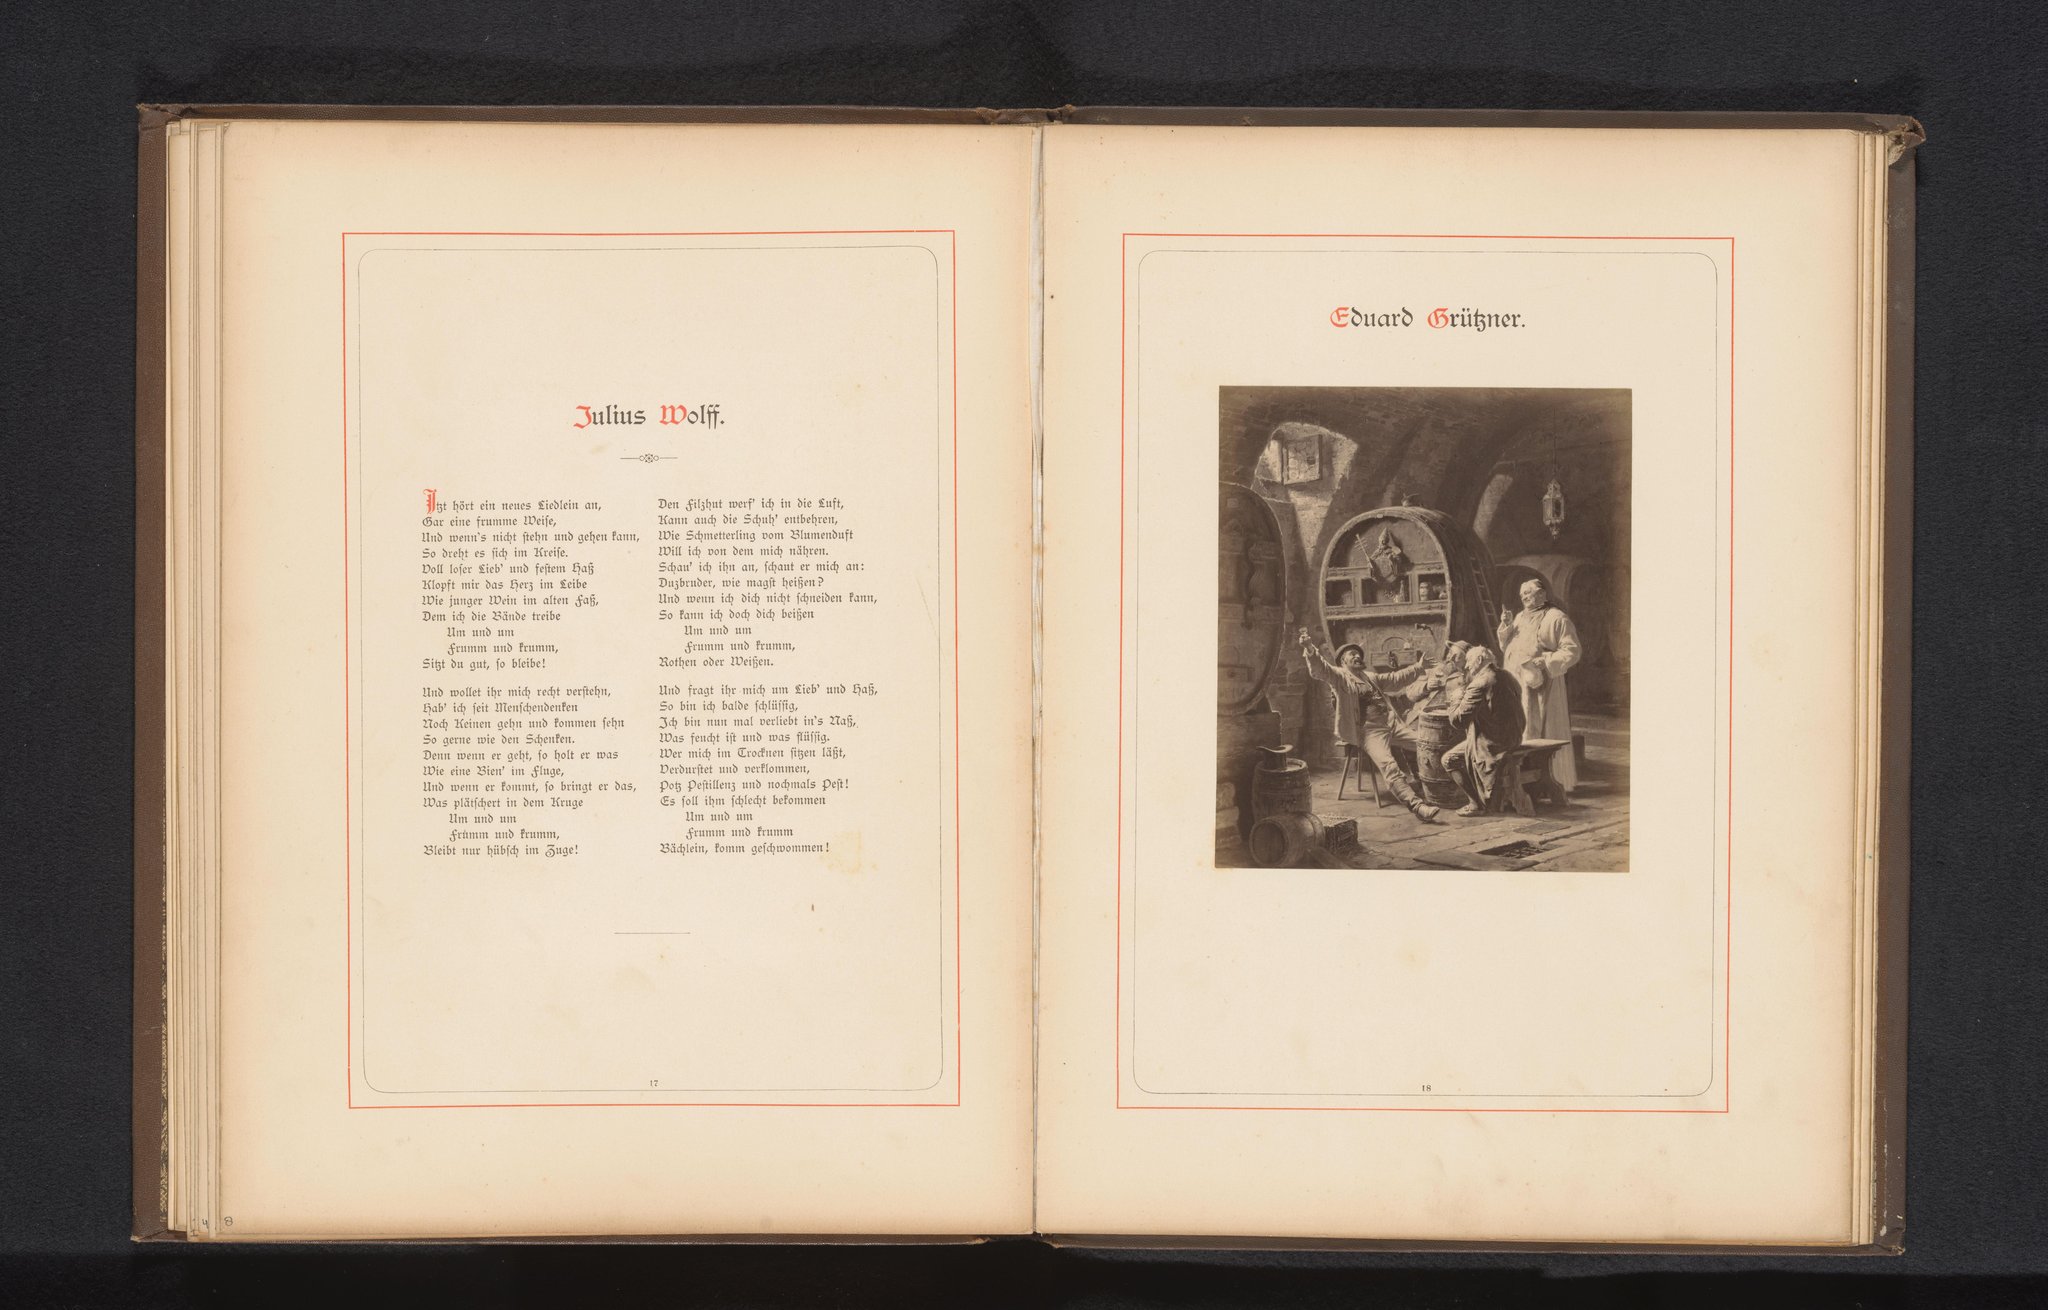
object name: reproduction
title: Fotoreproductie van een schilderij door Eduard von Grützner, voorstellende vier drinkende mannen waaronder een monnik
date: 1880-1885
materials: photographic support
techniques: albumen print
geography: munich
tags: monk(s), friar(s), picture, painting, drinking